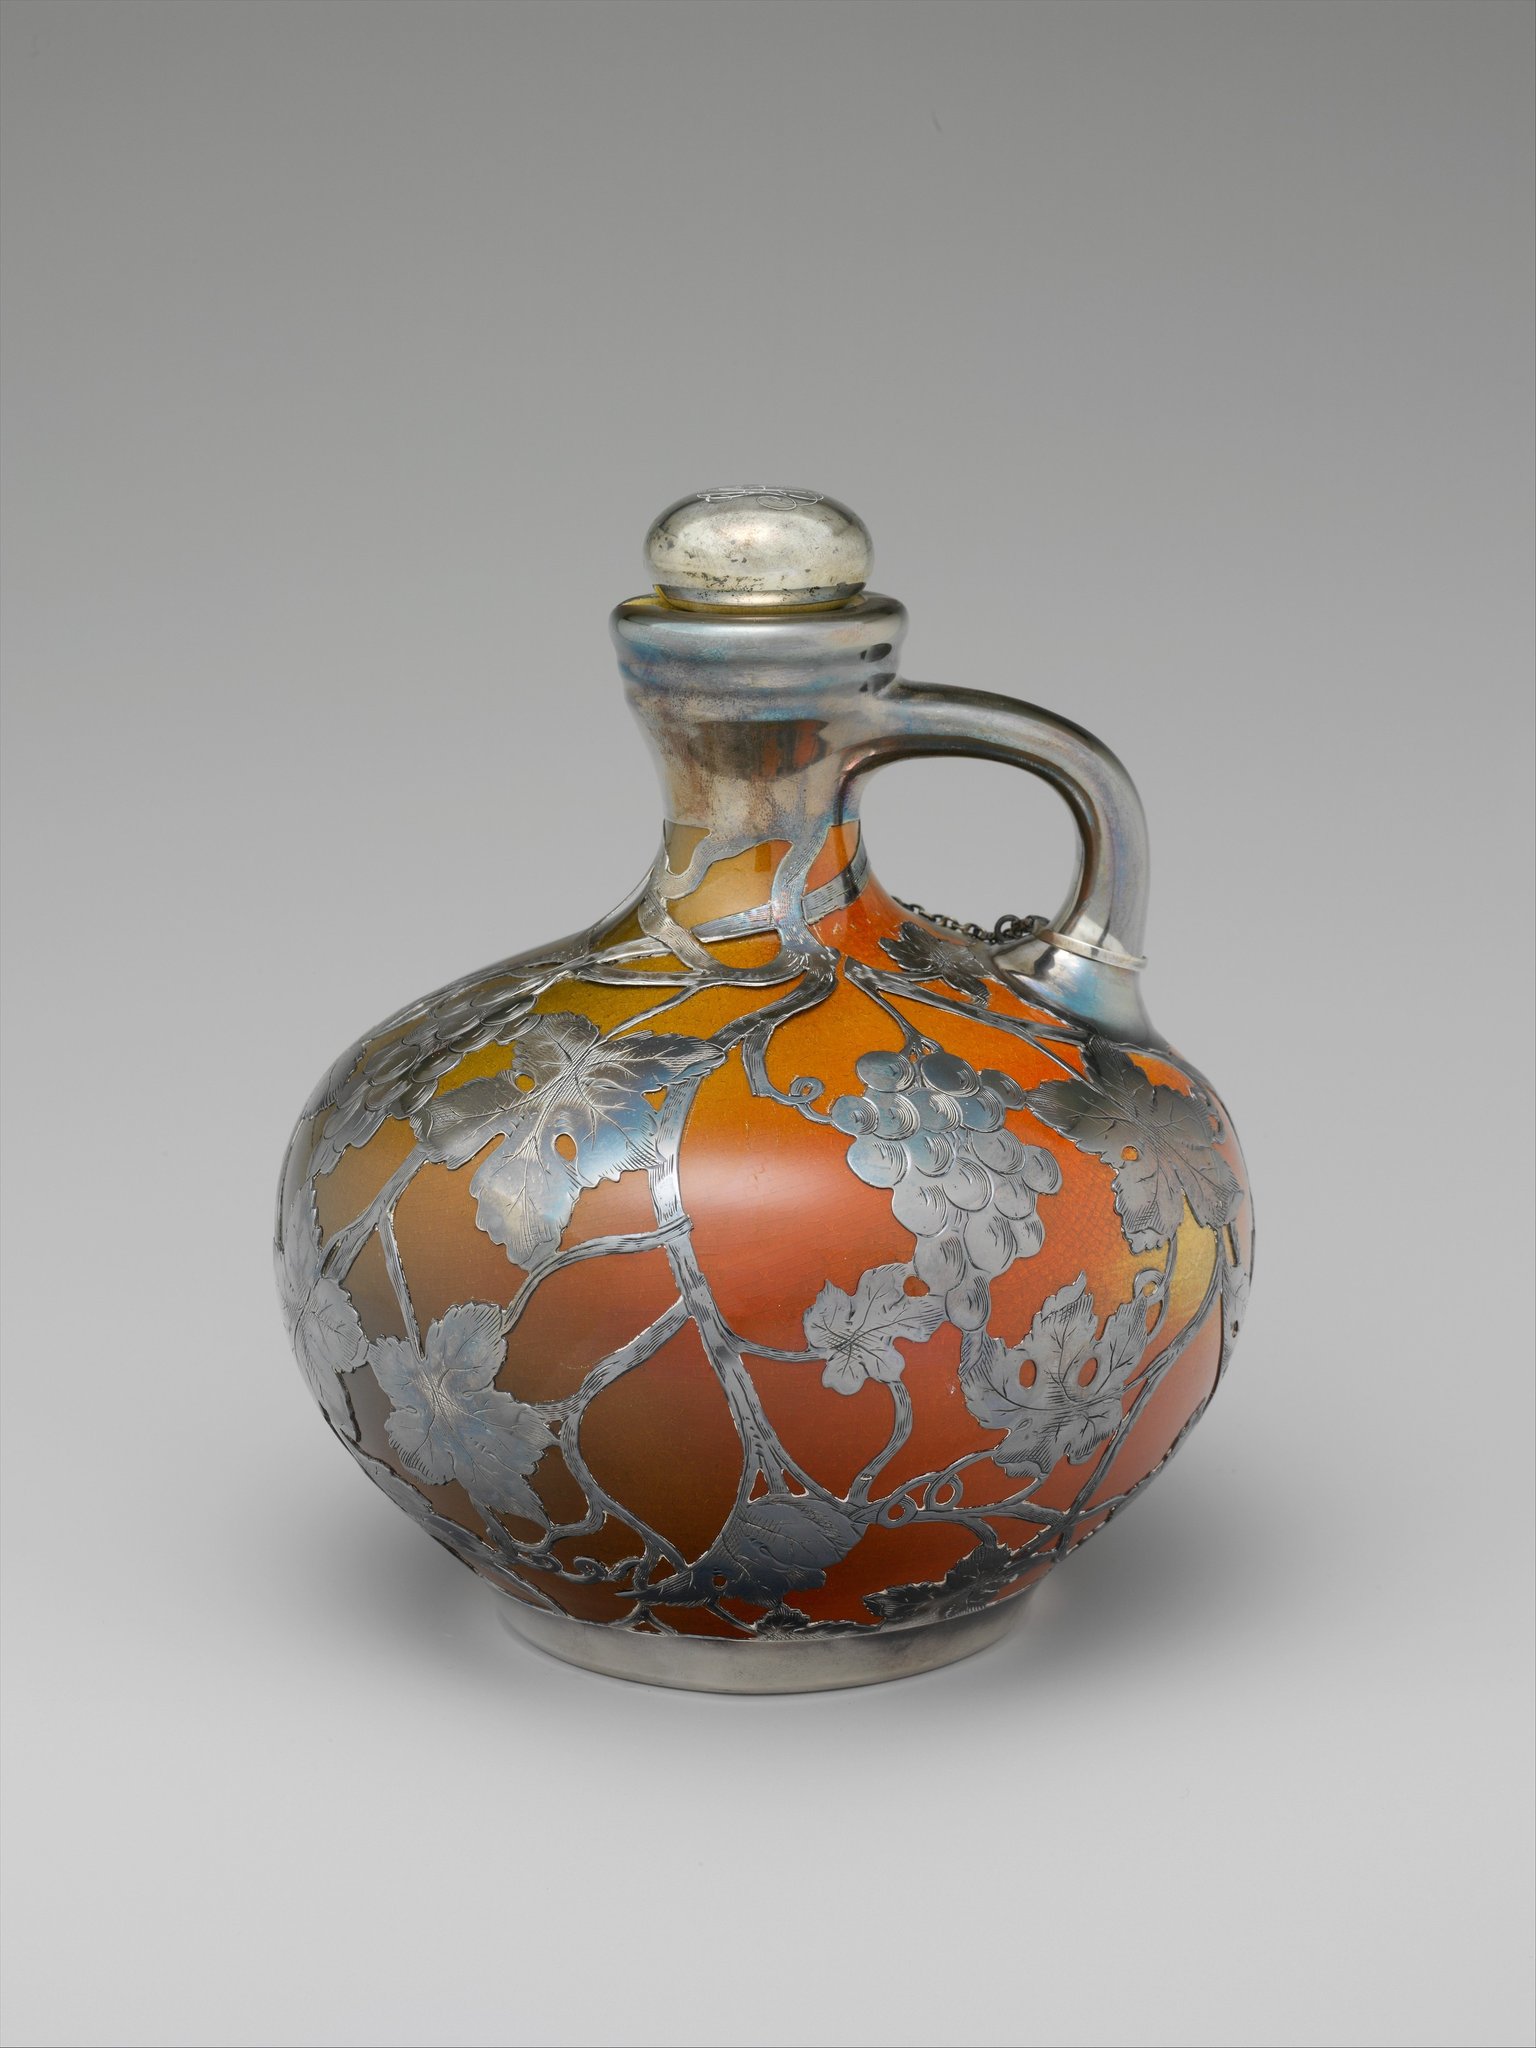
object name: jug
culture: american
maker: rookwood pottery company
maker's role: maker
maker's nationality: american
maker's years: 1880-1967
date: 1892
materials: earthenware, silver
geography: united states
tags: grapes,corn